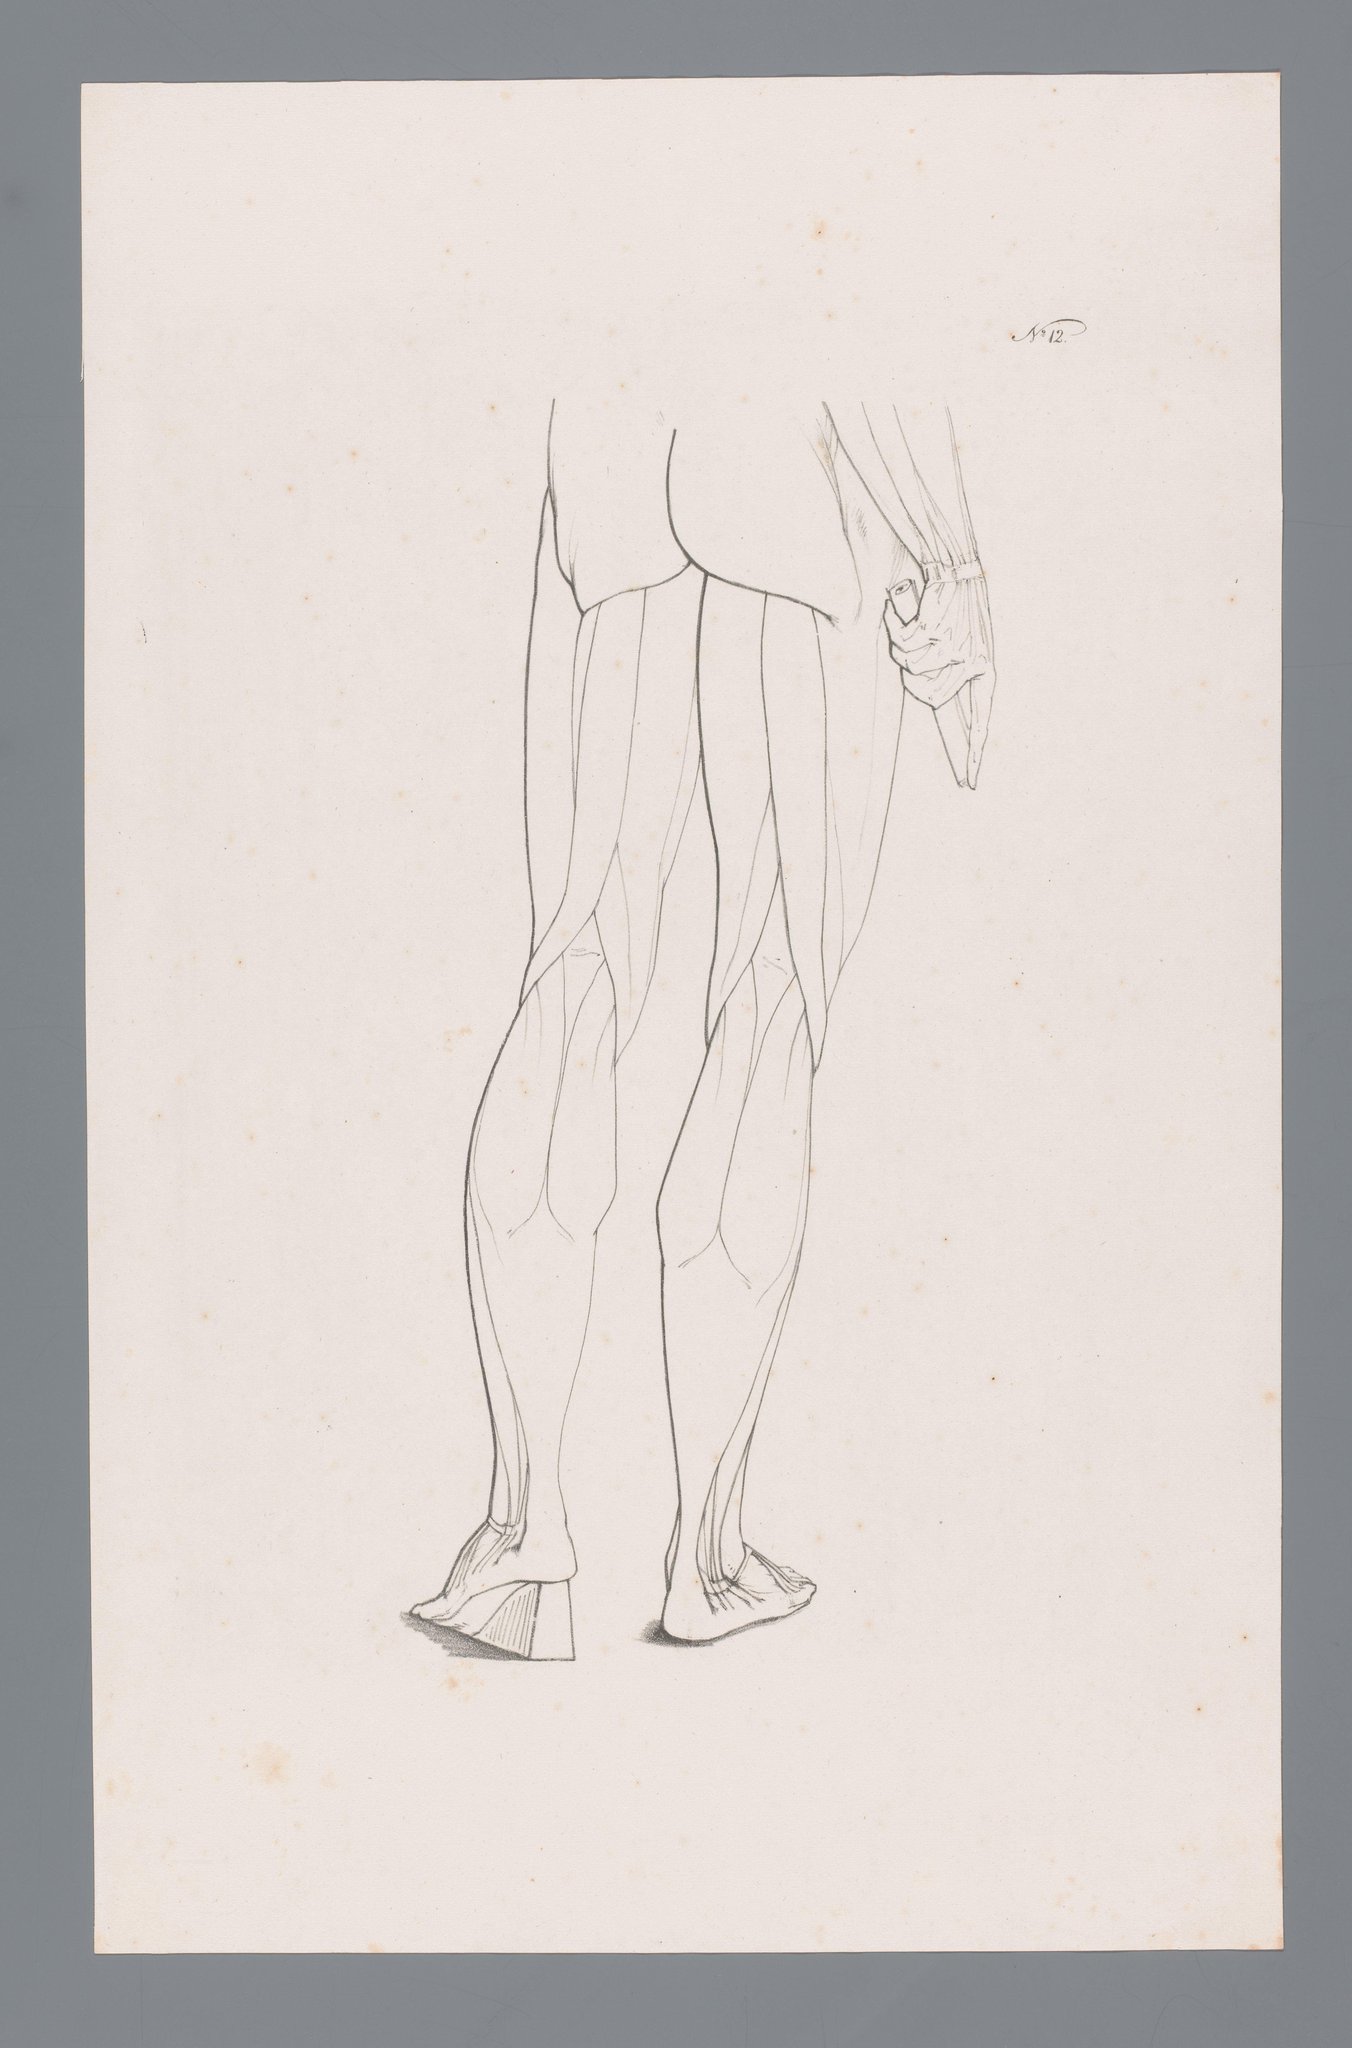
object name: print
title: Anatomie van een onderlichaam op de rug gezien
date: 1828-1830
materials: paper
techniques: lithograph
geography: amsterdam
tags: legs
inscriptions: collector's mark: Lugt 2228, watermark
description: Onderdeel van een omslag met in totaal achttien anatomische voorstellingen.